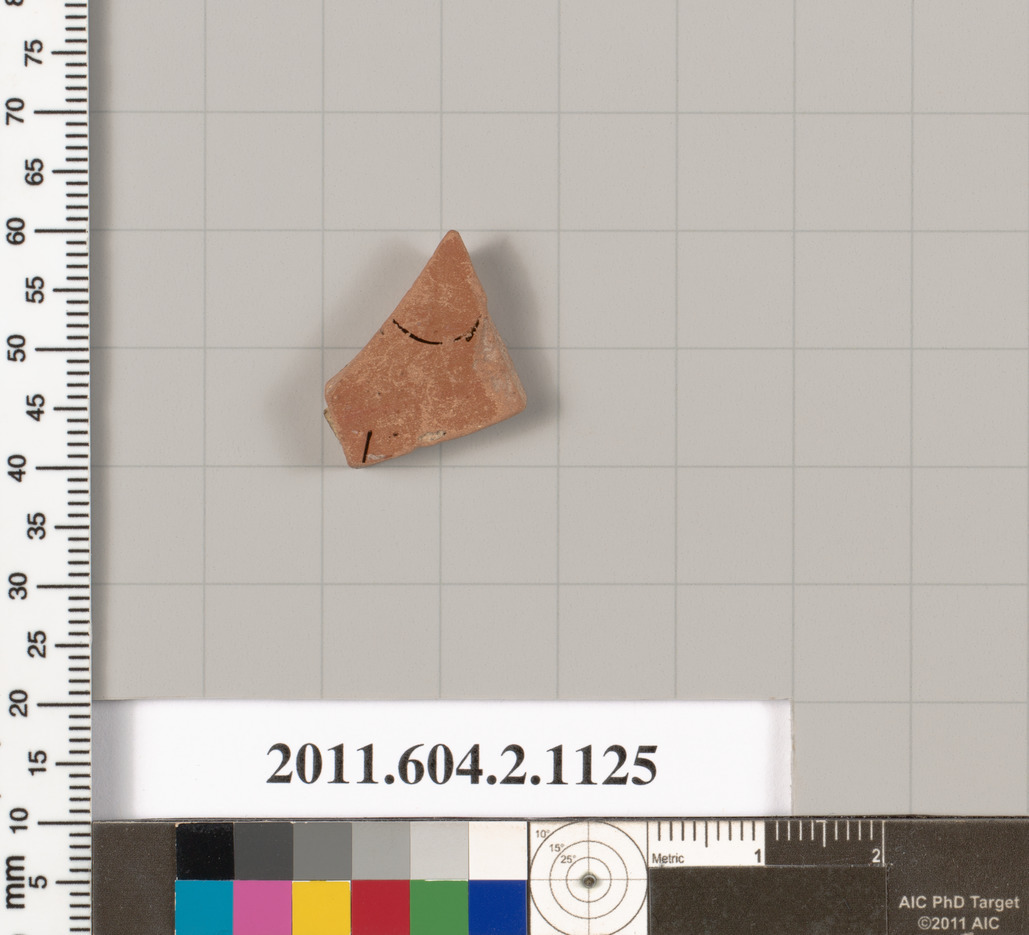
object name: lekythos fragment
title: Terracotta fragment of a lekythos (oil flask)?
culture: greek, attic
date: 475-451 BCE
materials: terracotta